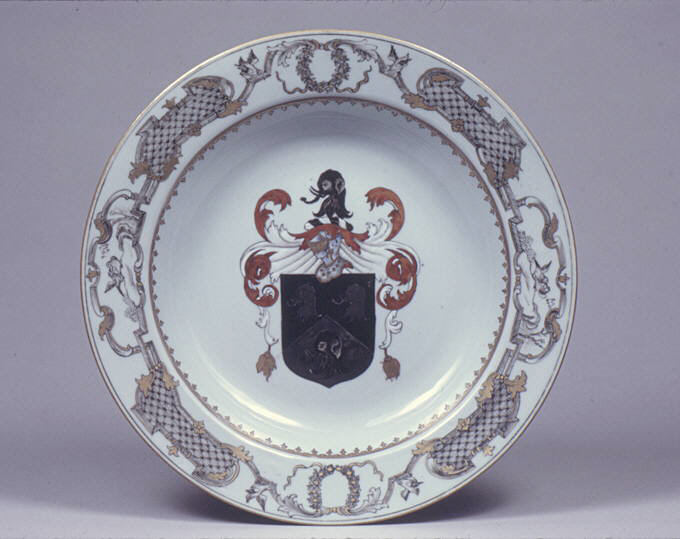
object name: plate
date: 1735-1740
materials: hard paste porcelain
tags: coat of arms